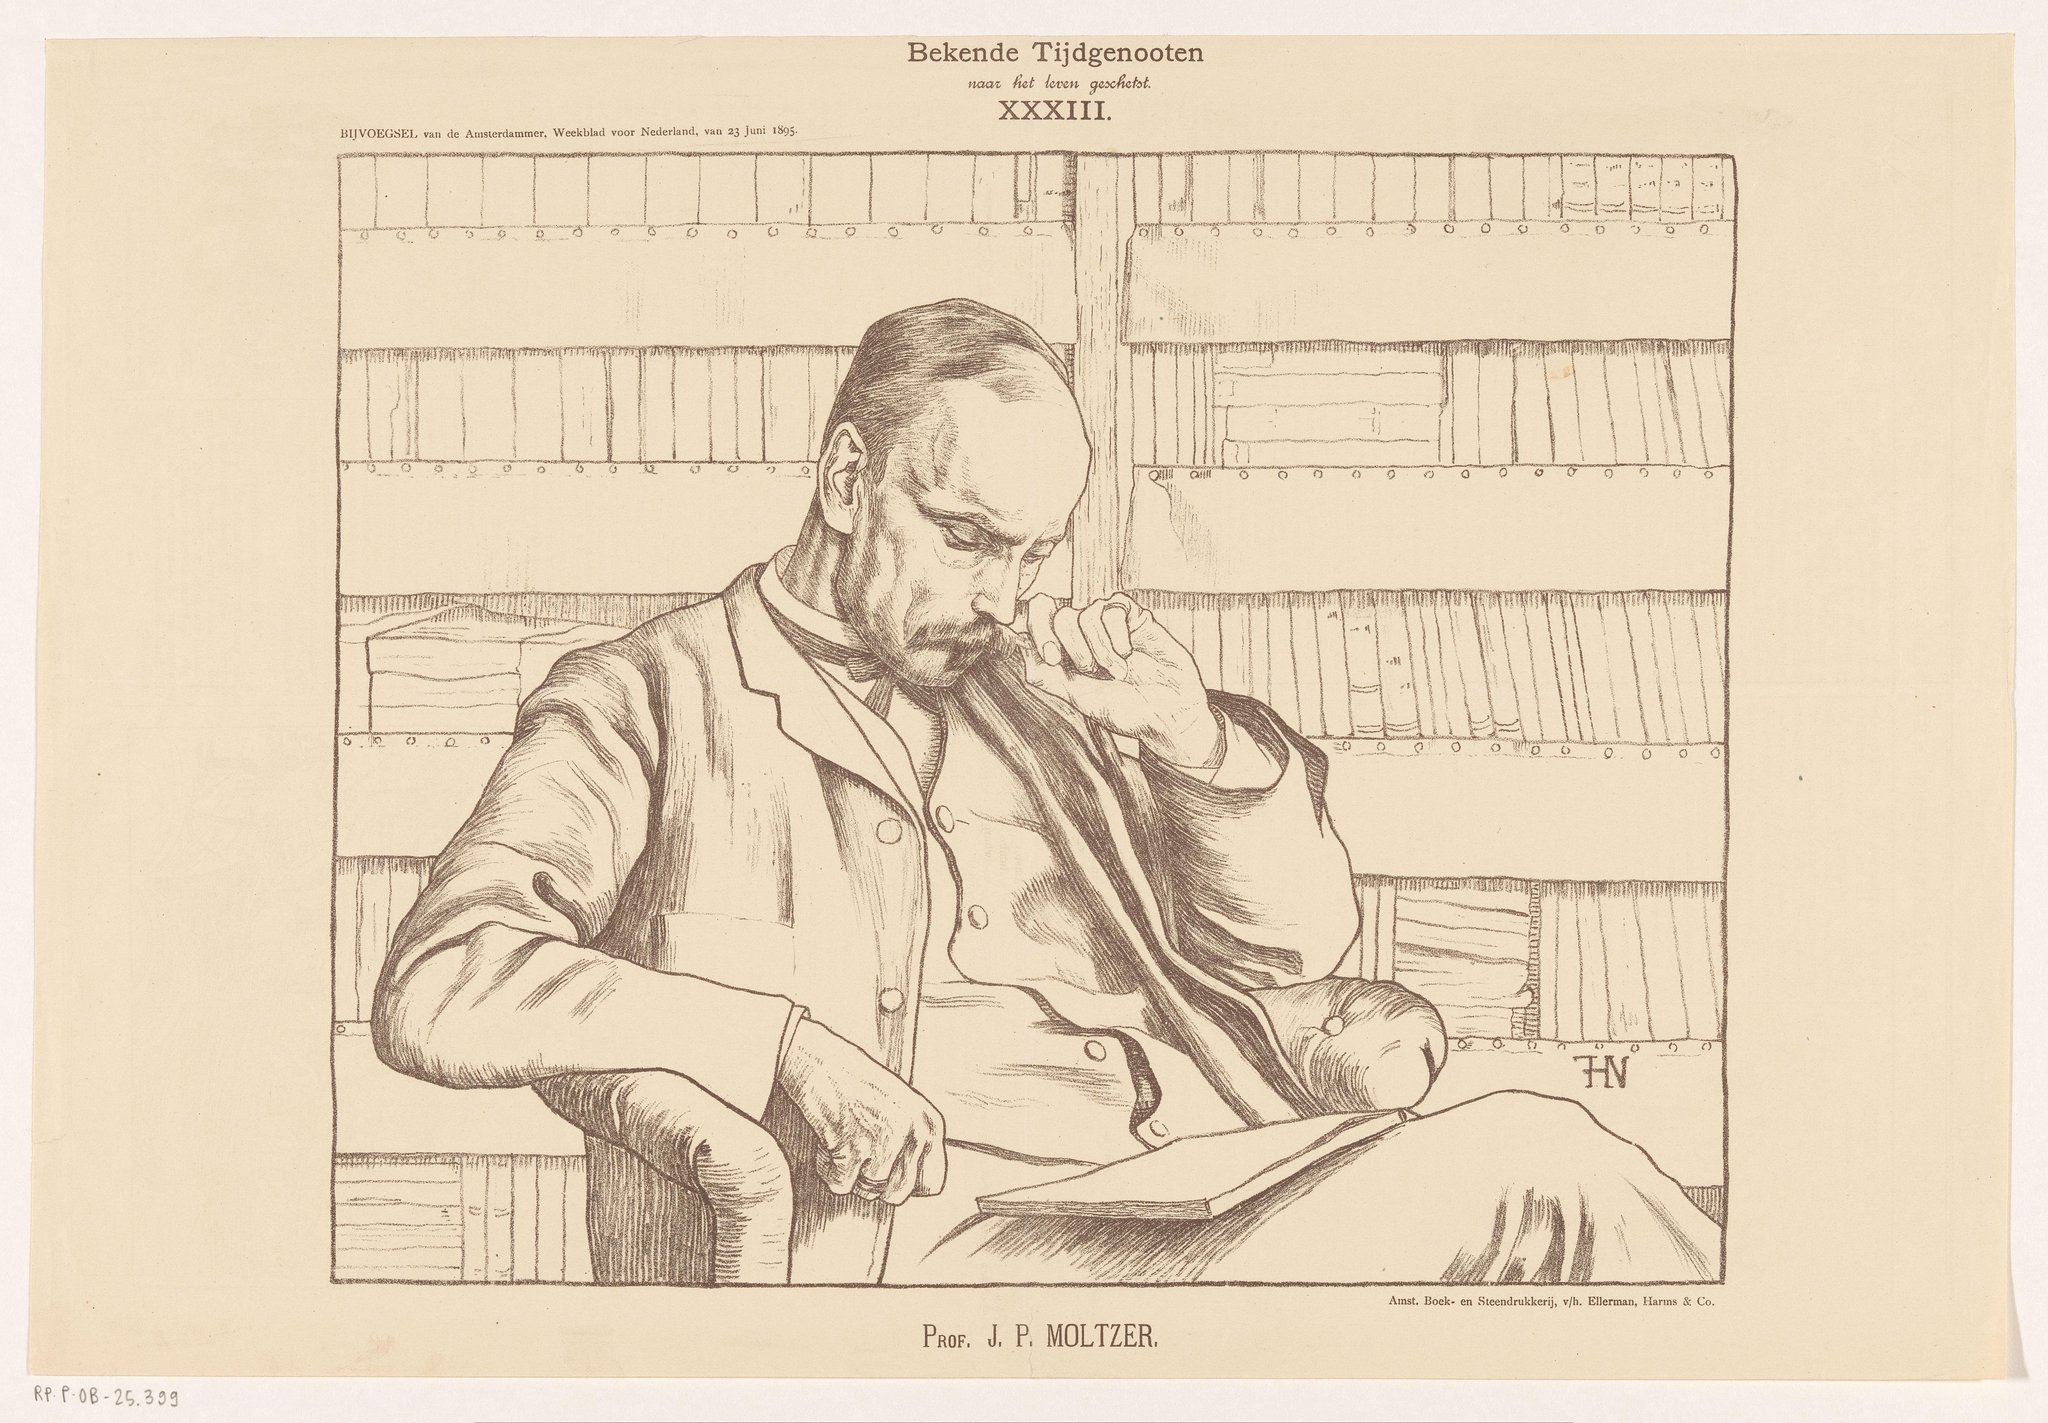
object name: print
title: Portret van Jacob Pieter Moltzer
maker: ferdinand hart nibbrig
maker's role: draughtsman, painter, print maker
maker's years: 1866-1915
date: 1895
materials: paper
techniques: lithograph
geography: amsterdam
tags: jacob pieter moltzer, reading, historical persons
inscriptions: collector's mark: Lugt 2228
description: Een portret van rechtsgeleerde Jacob Pieter Moltzer, die gezeten in een stoel een boek leest.